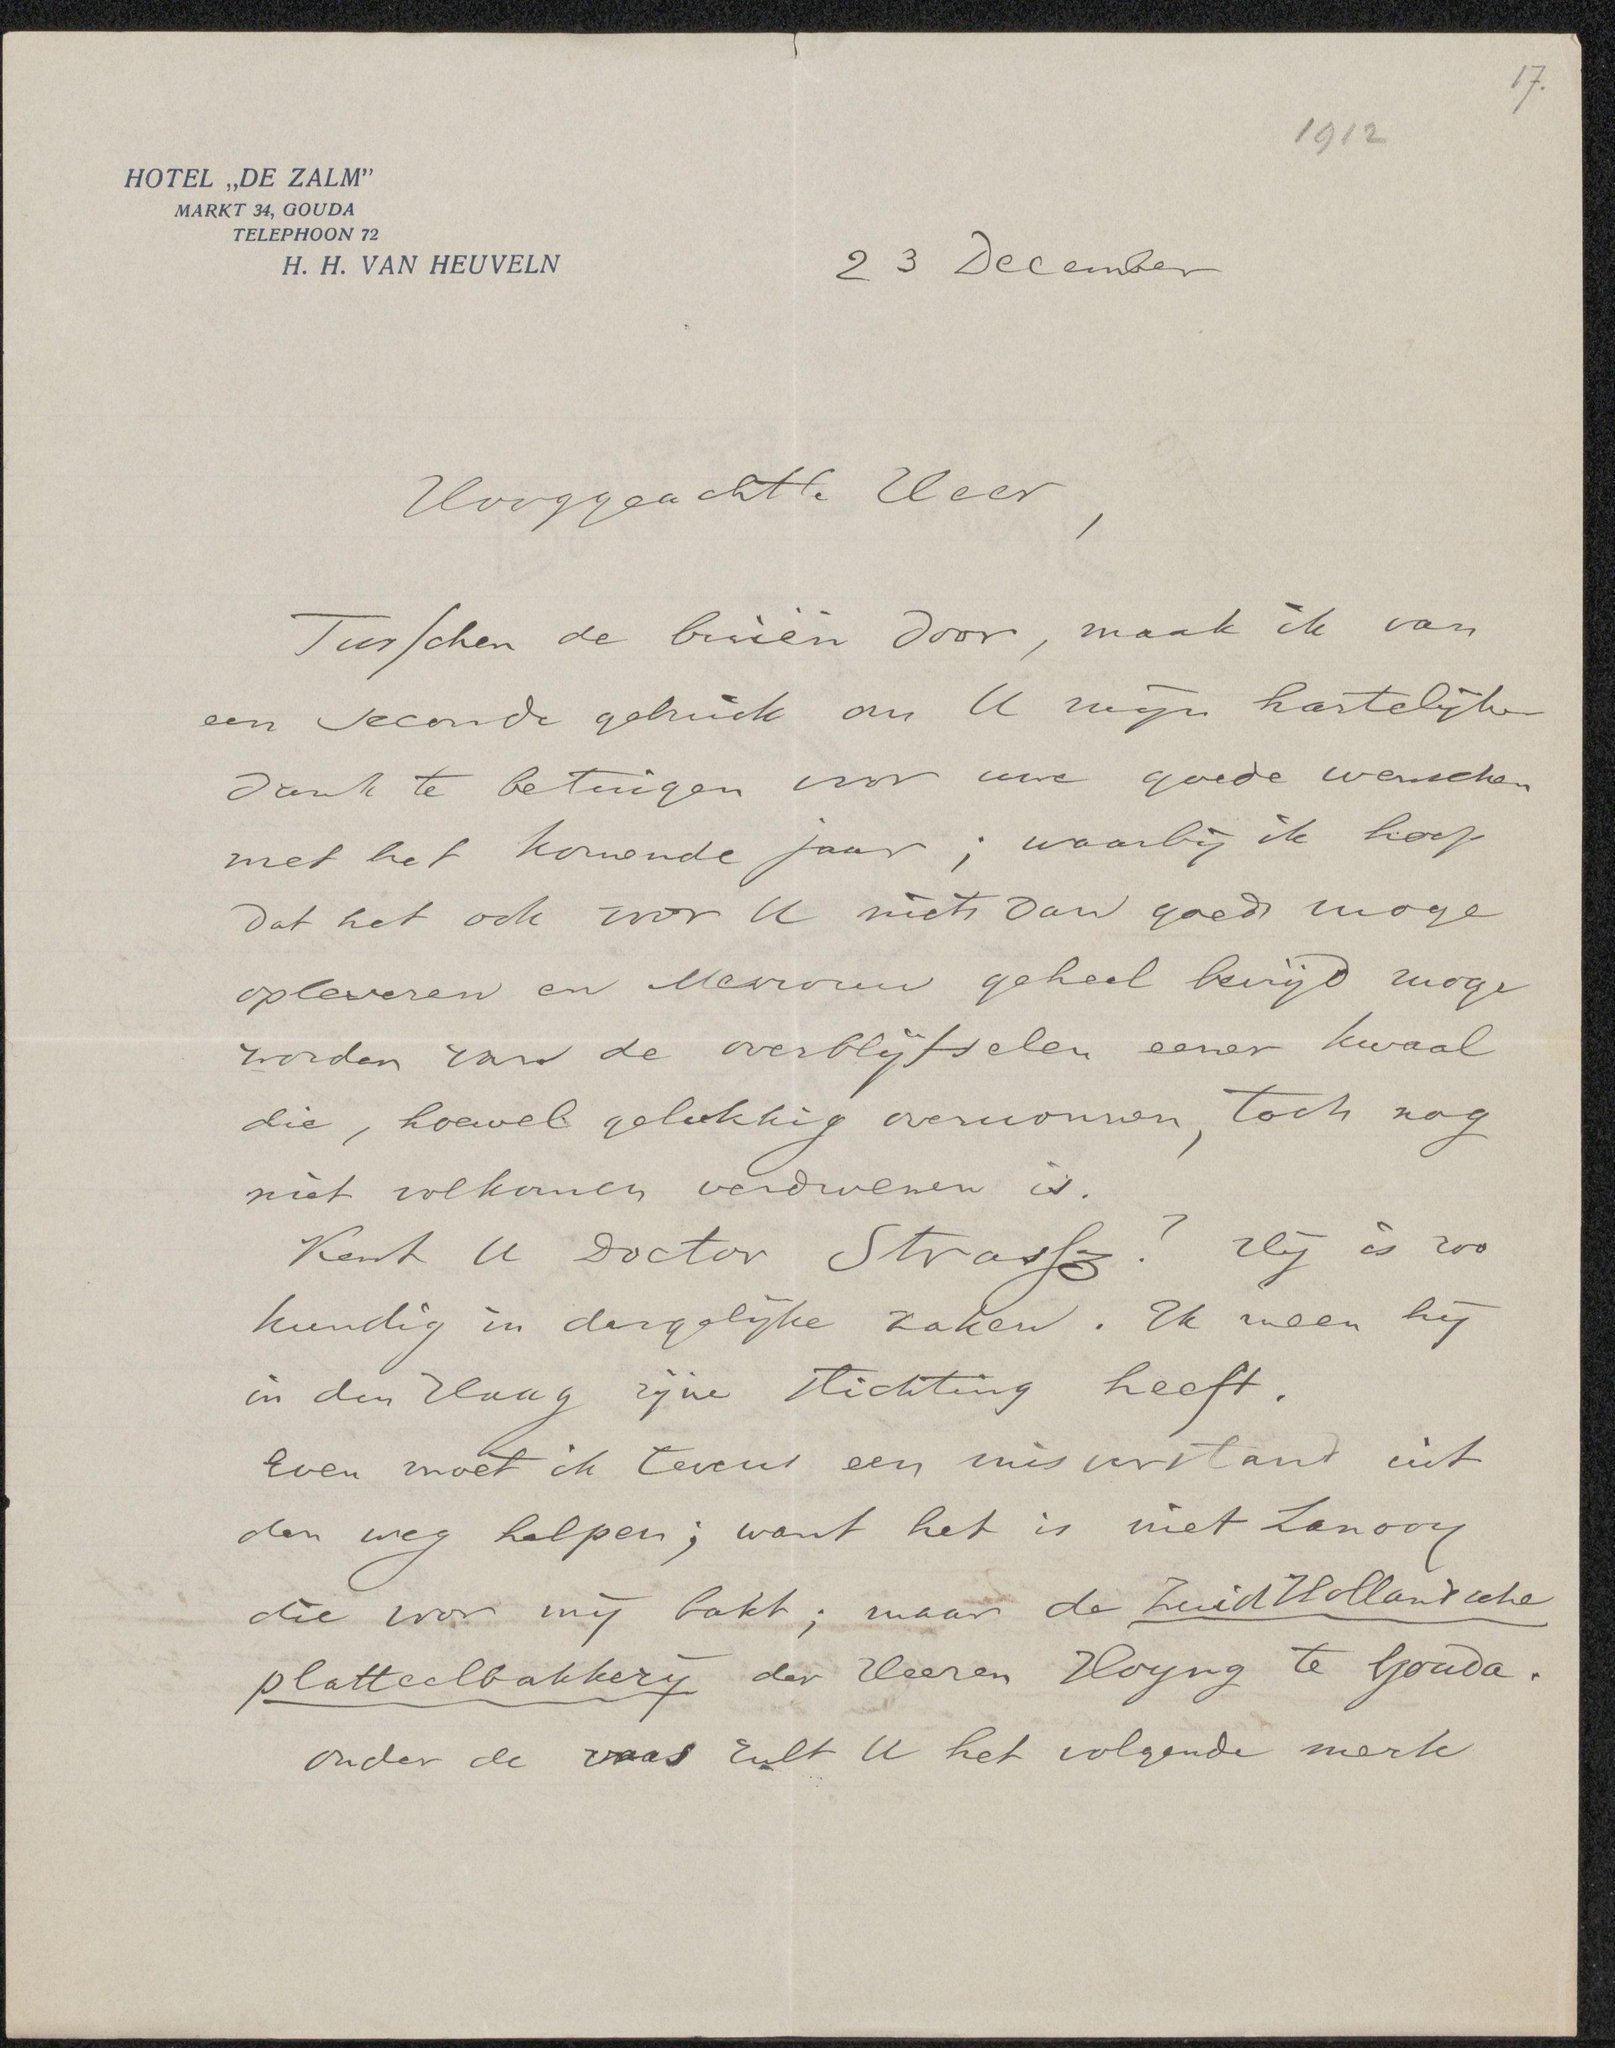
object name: letter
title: Brief aan Pieter Haverkorn van Rijsewijk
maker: theo colenbrander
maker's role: draughtsman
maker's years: 1841-1930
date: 1851-1915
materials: ink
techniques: pen, printing, writing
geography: gouda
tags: gouda, painter, daniël harkink, chris lanooy, pieter haverkorn van rijsewijk, applied arts, arts and crafts; industrial design, trade mark, trade token, trade sign, trade card, diseases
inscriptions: collector's mark: ‘RPK’, watermark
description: Brief gedateerd 23 December door schrijver, met toevoeging 1912 in latere hand.